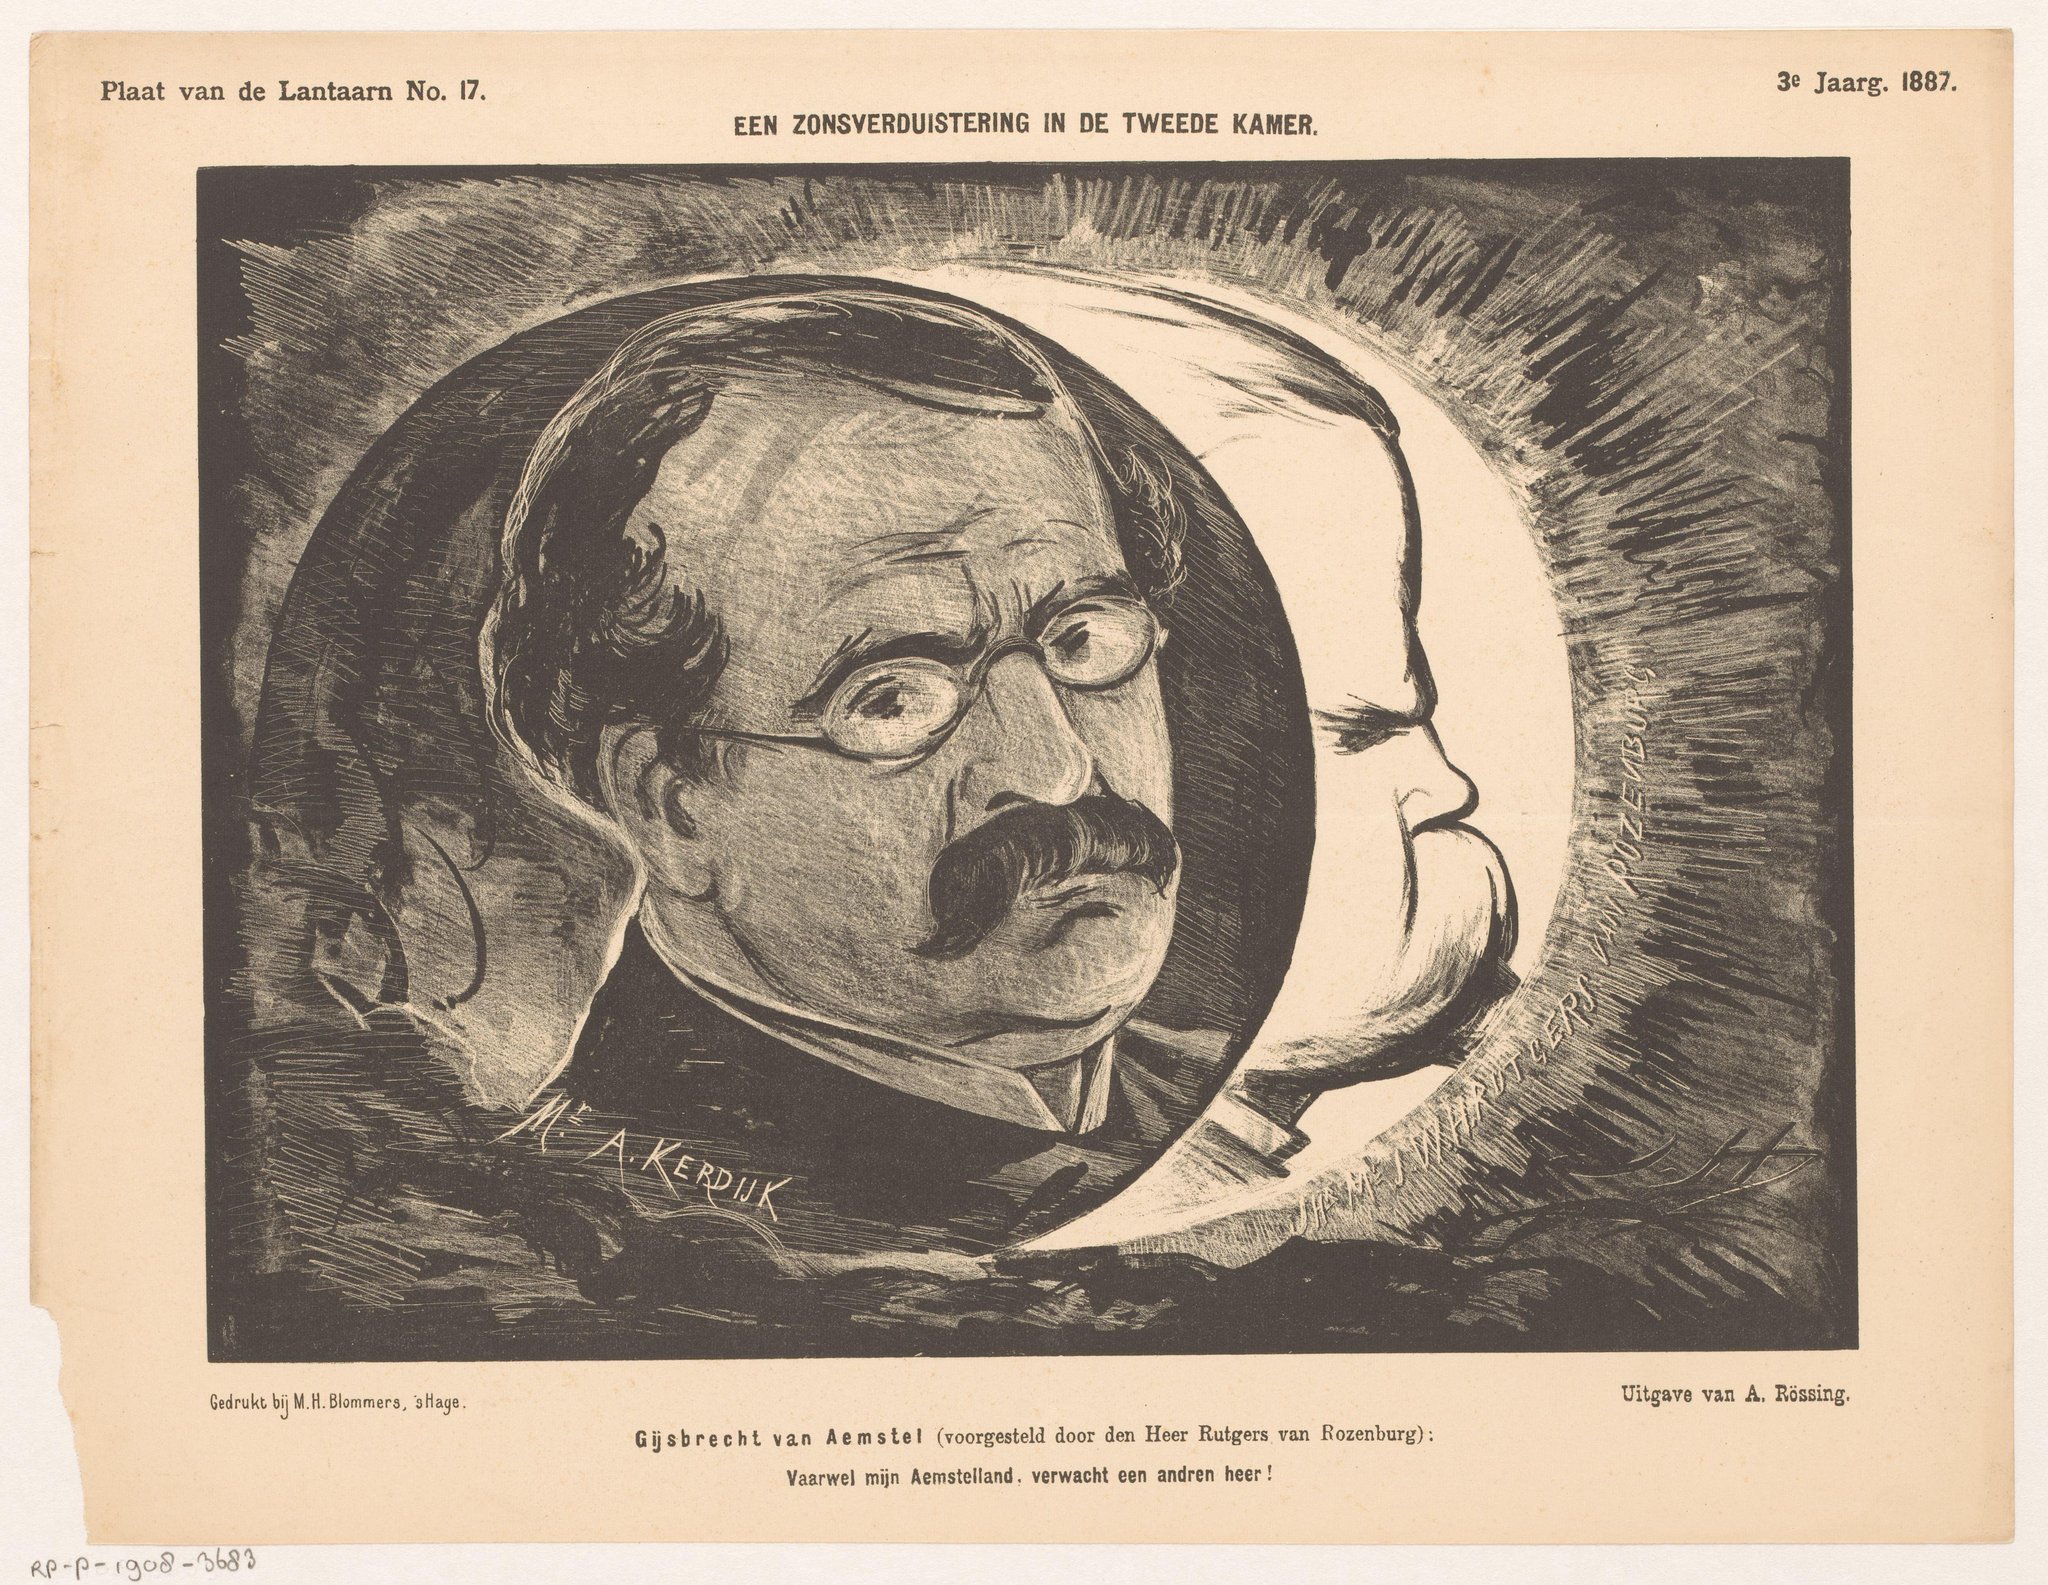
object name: print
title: Een zonsverduistering in de Tweede Kamer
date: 1887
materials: paper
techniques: lithograph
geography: netherlands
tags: solar eclipse, political caricatures and satires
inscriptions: collector's mark: Lugt 2228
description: Het portret van Jan Willem Hendrik Rutgers van Rozenburg is de zon. Arnold Kerdijk is de maan die voor de zon schuift. Hij werd in 1887 gekozen tot lid van de Tweede Kamer namens het kiesdistrict Amsterdam. Onder de afbeelding een citaat uit Gijsbrecht van Aemstel. Deze prent werd uitgegeven bij De Lantaarn.